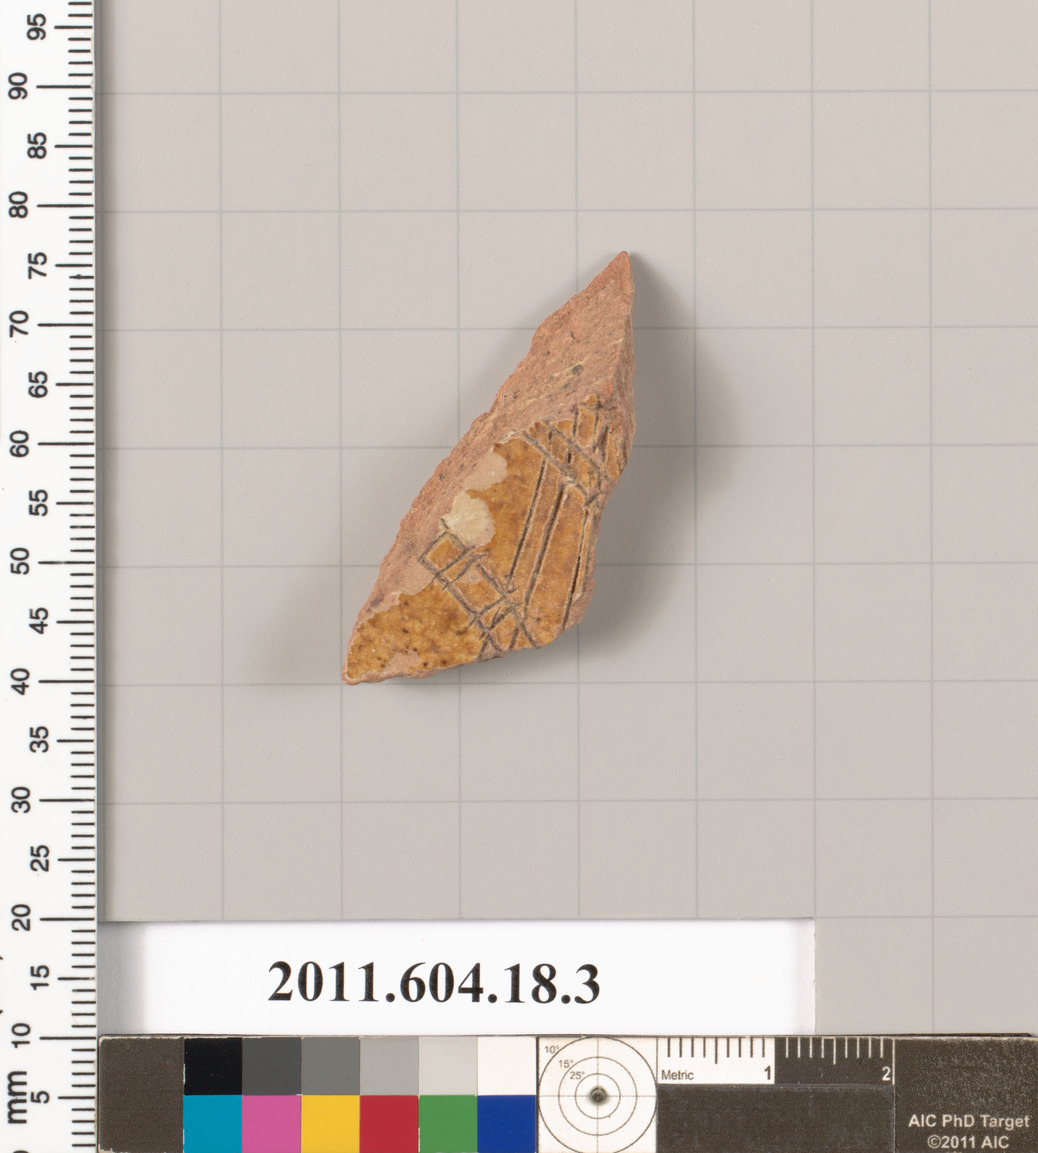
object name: plate fragment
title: Fragment of a glazed ceramic plate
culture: byzantine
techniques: engraving